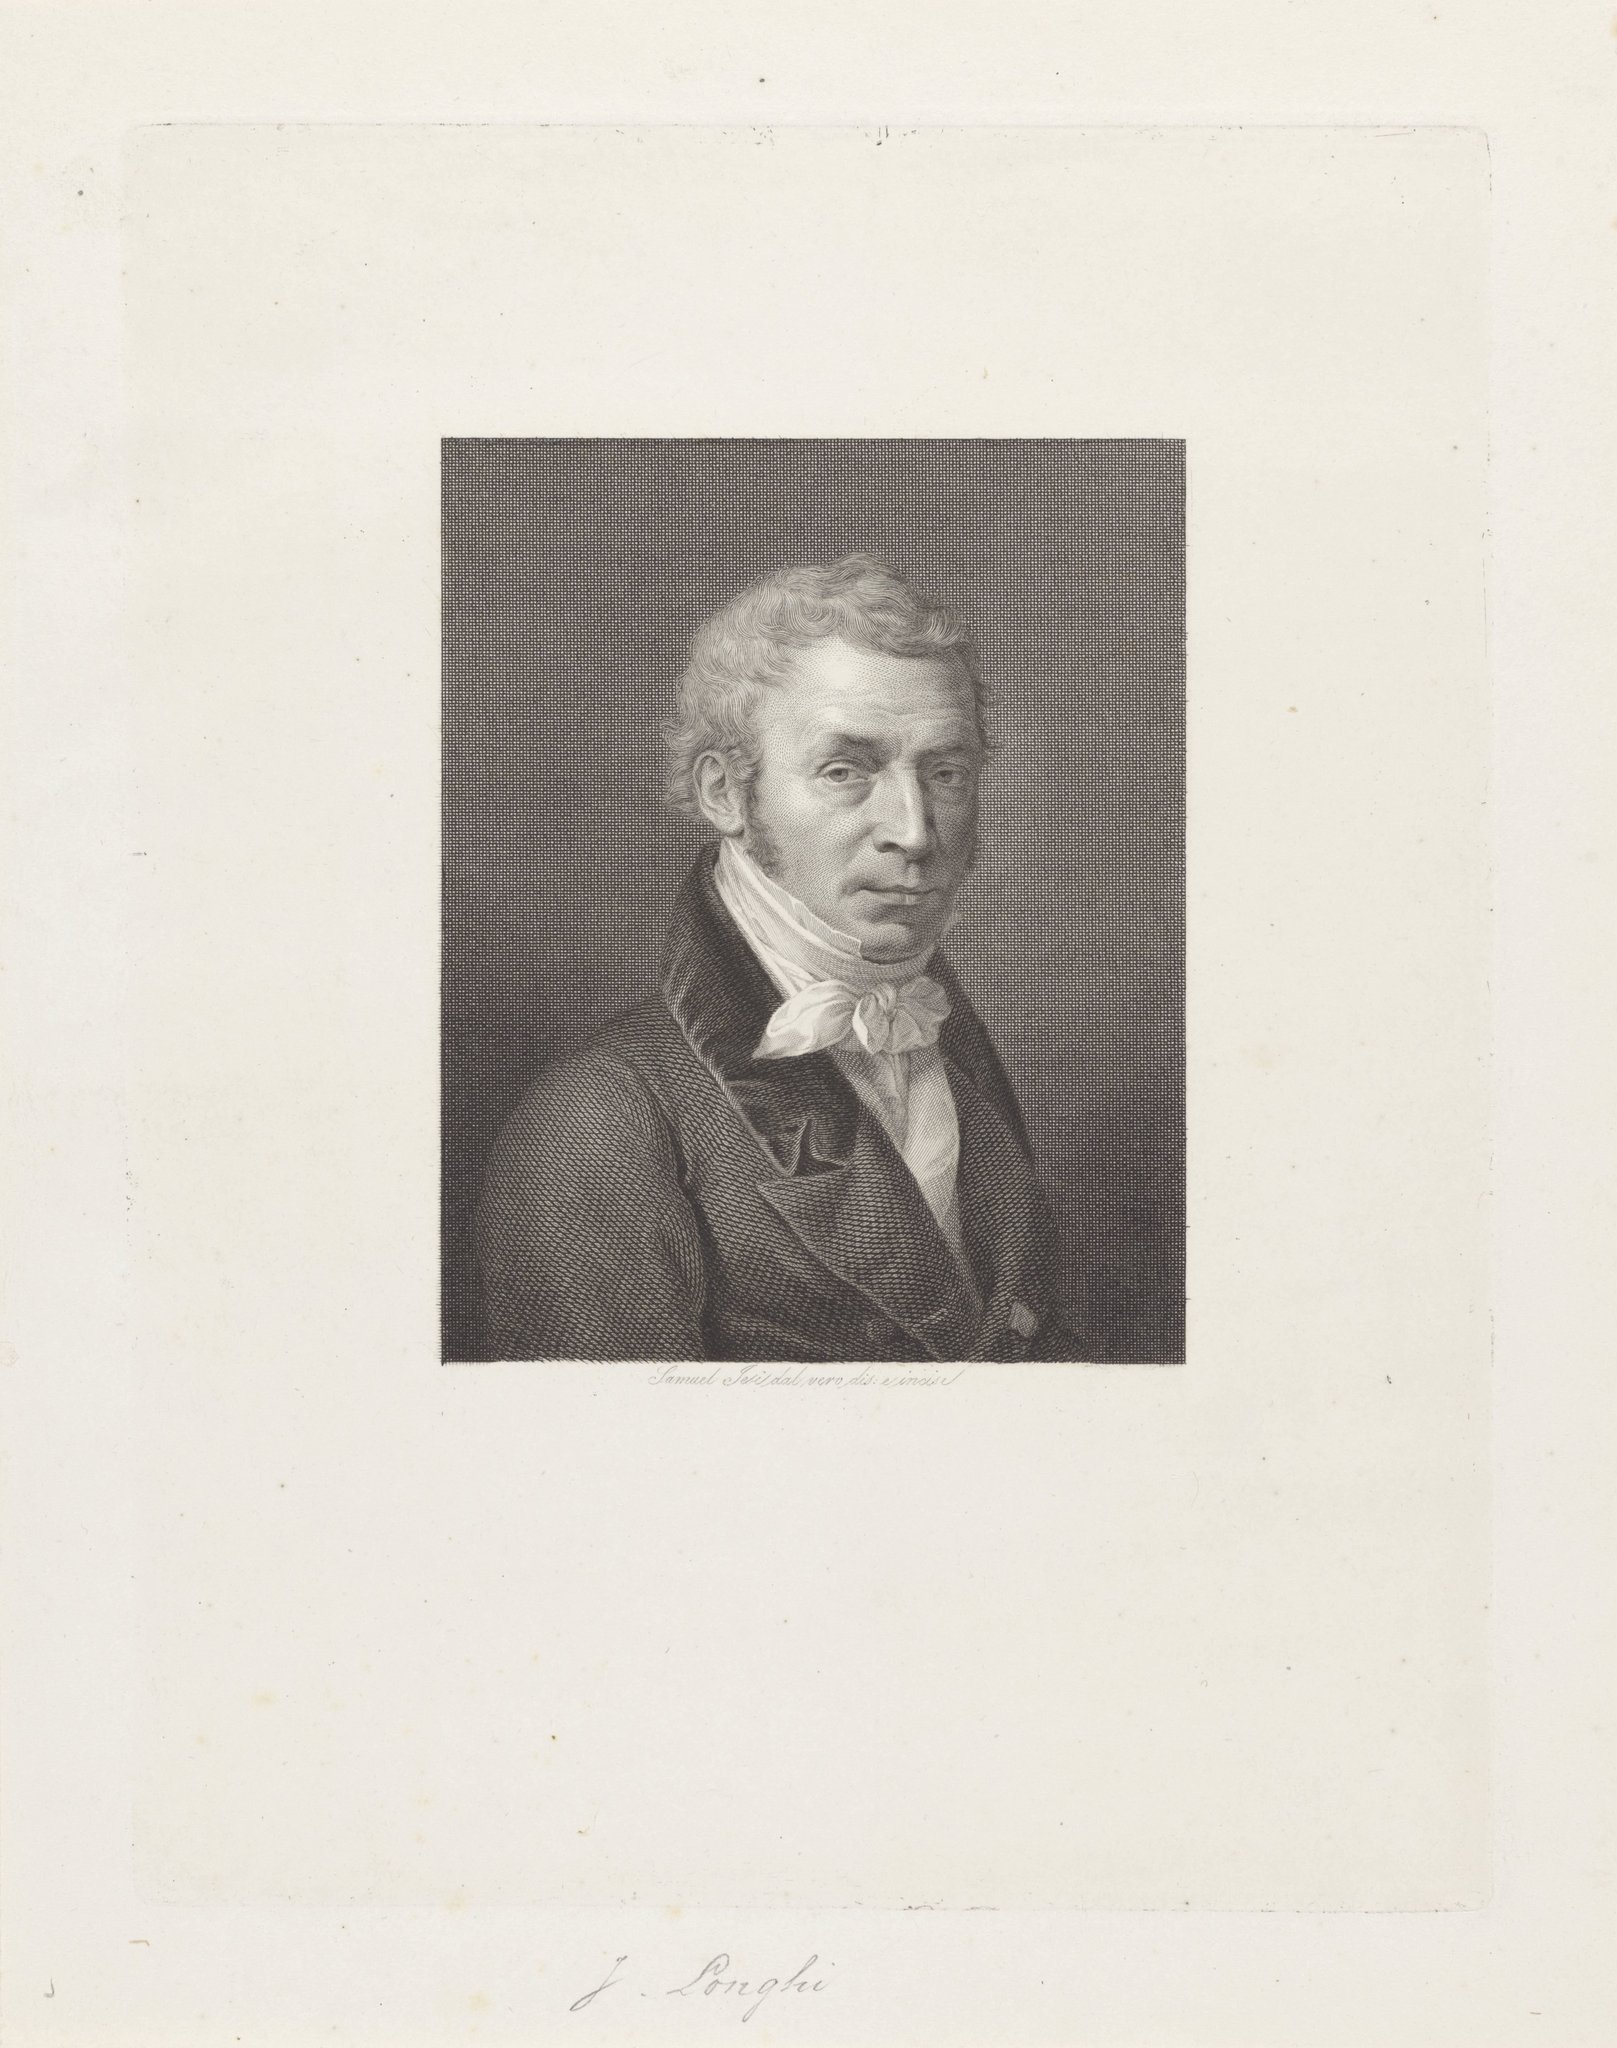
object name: print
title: Portret van prentmaker Giuseppe Longhi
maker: samuele jesi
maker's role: print maker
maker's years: 1788-1853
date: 1798-1853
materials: paper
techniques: engraving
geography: italy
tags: draughtsman, giuseppe longhi, historical persons, portrait, self-portrait of artist